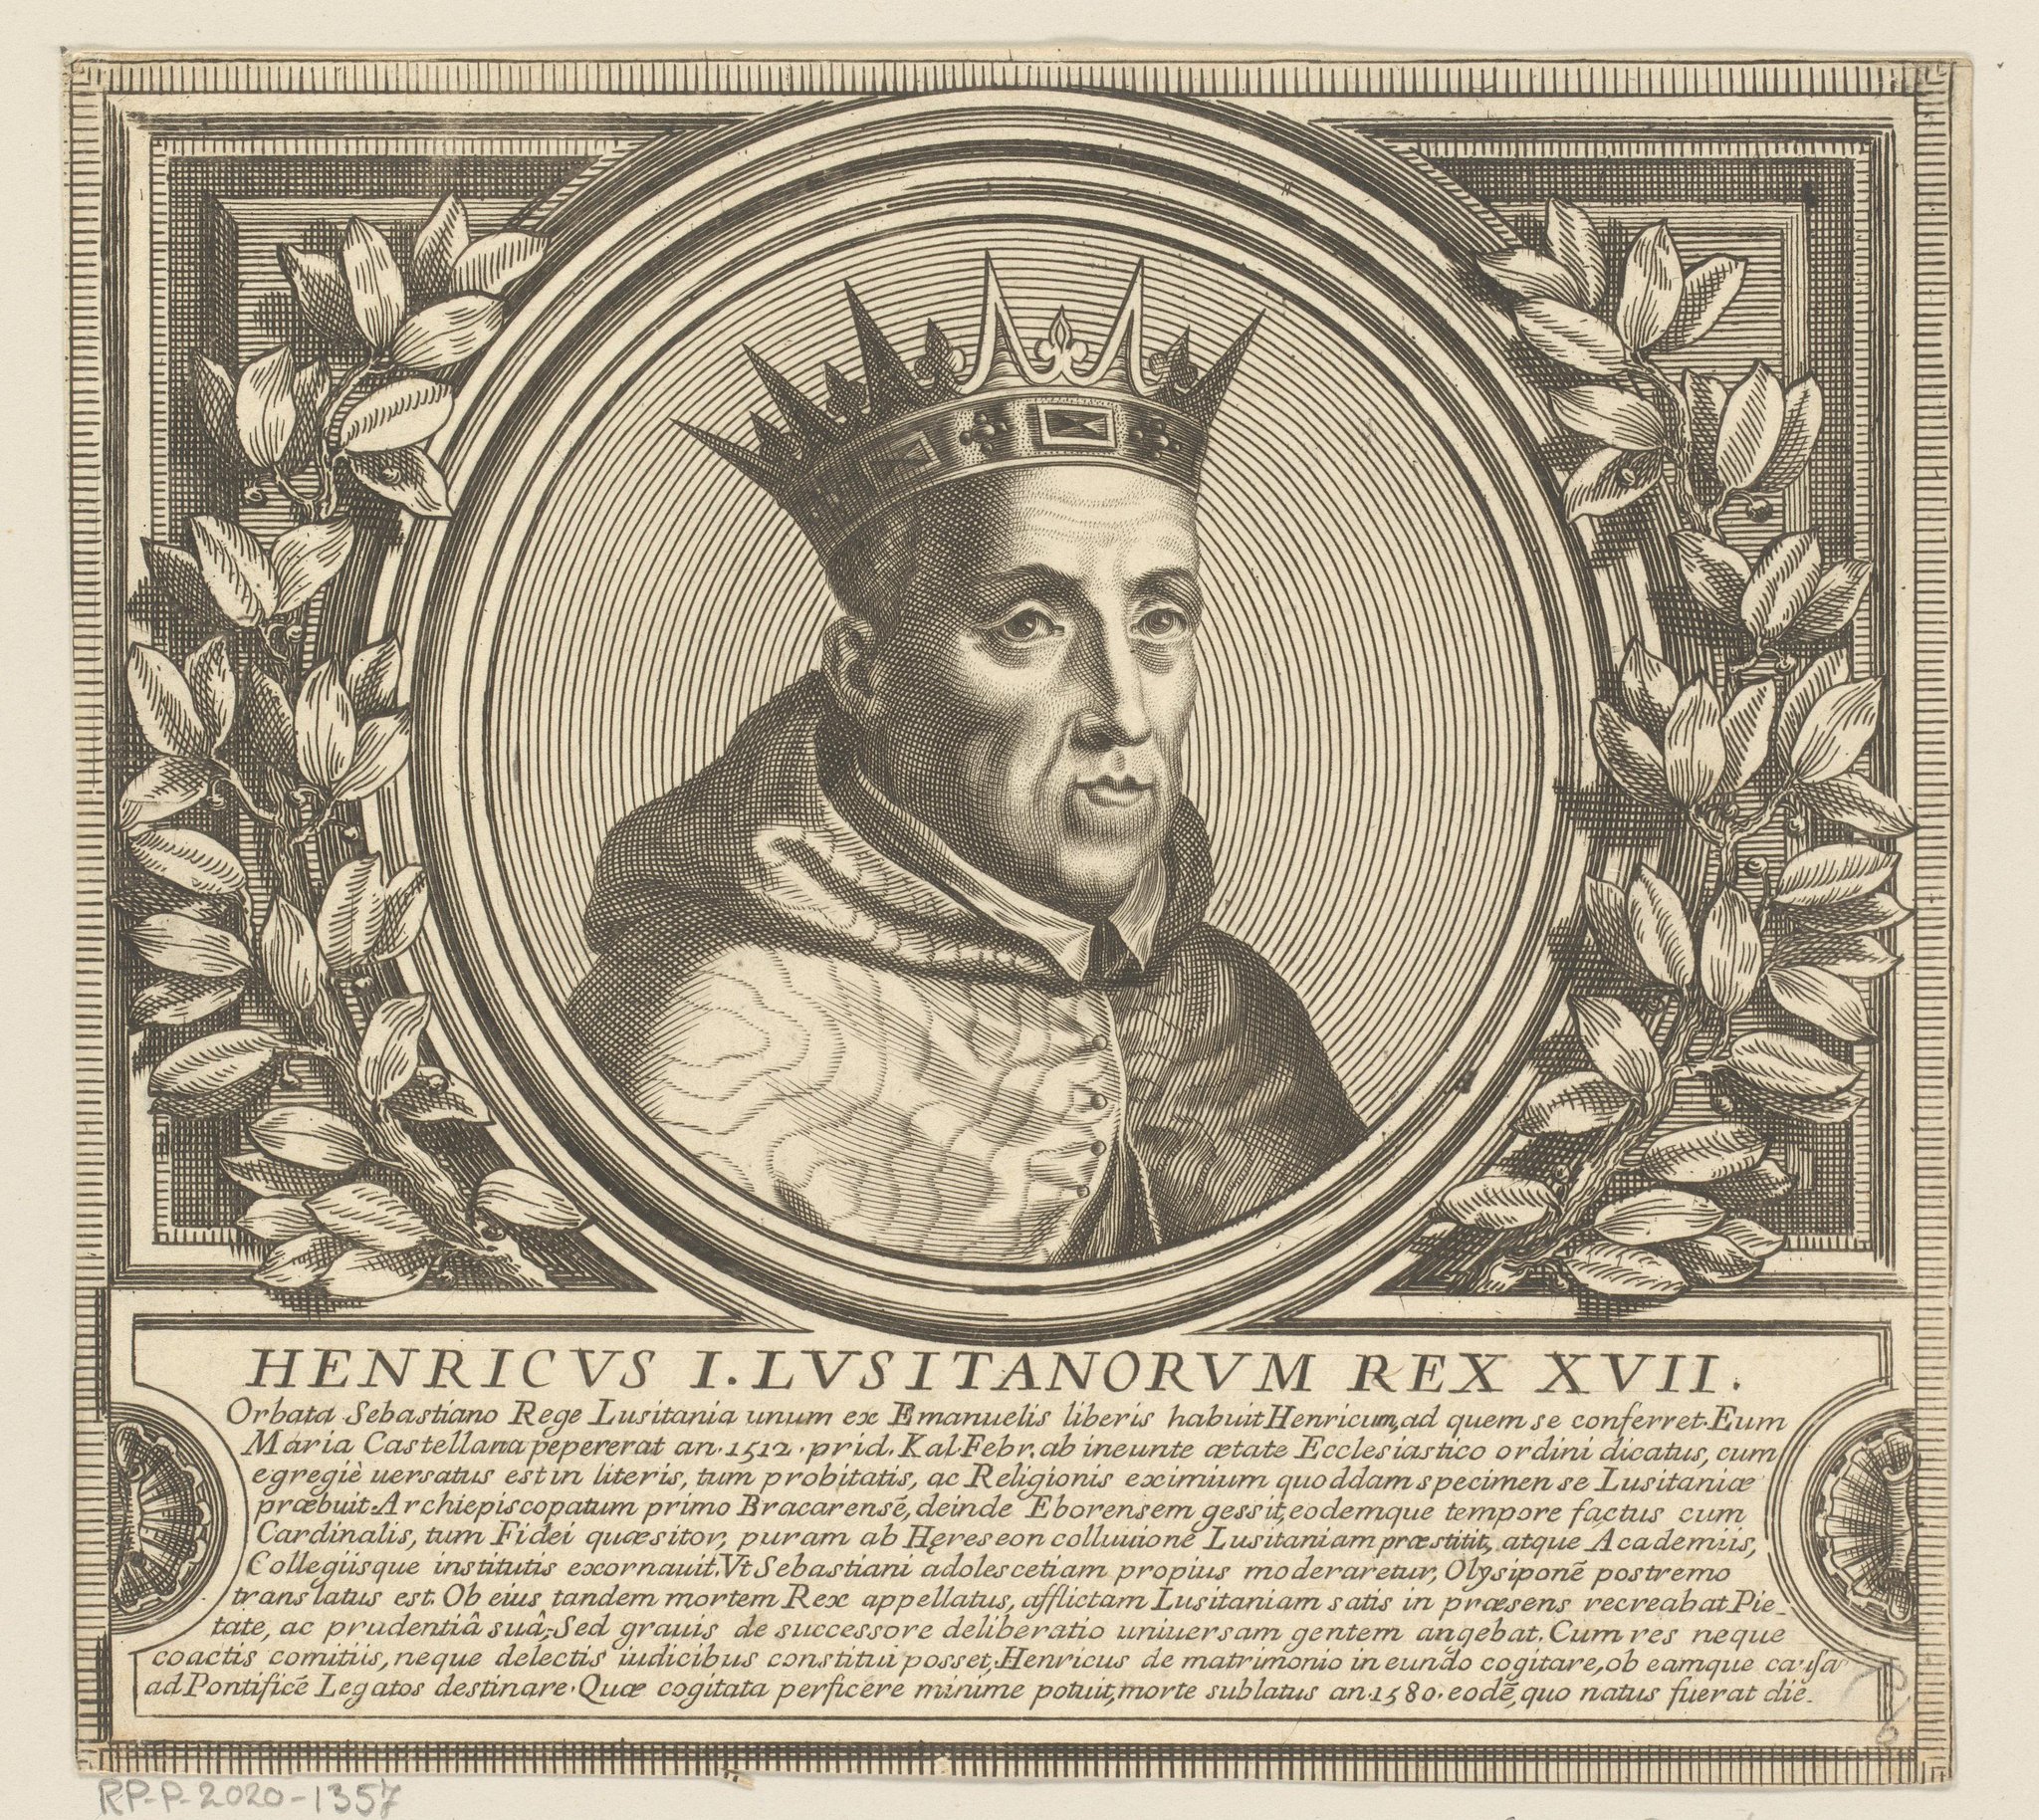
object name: print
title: Henricus I. Lusitanorum Rex XVII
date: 1708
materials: paper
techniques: engraving, etching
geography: rome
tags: historical persons, king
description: Portret afkomstig van een grote prent, getiteld 'Series potentissimorum Regum Lusitaniae iconobus illustrata (...)', bestaande uit meerdere bladen die samengevoegd konden worden, uitgegeven door Giovanni Giacomo de' Rossi in 1708.